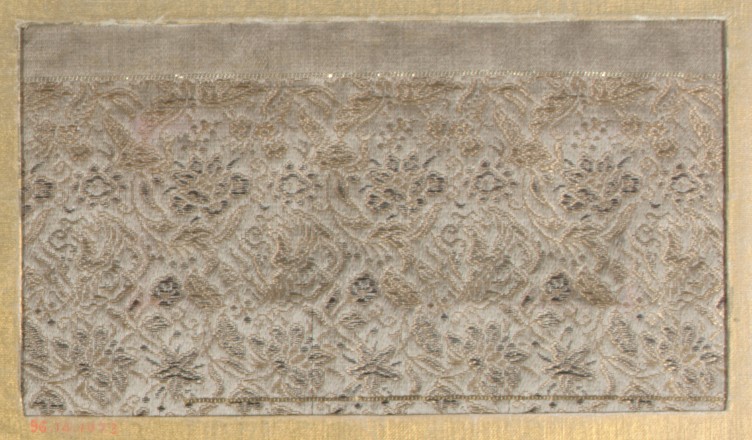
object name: piece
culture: japanese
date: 1701-1900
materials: silk